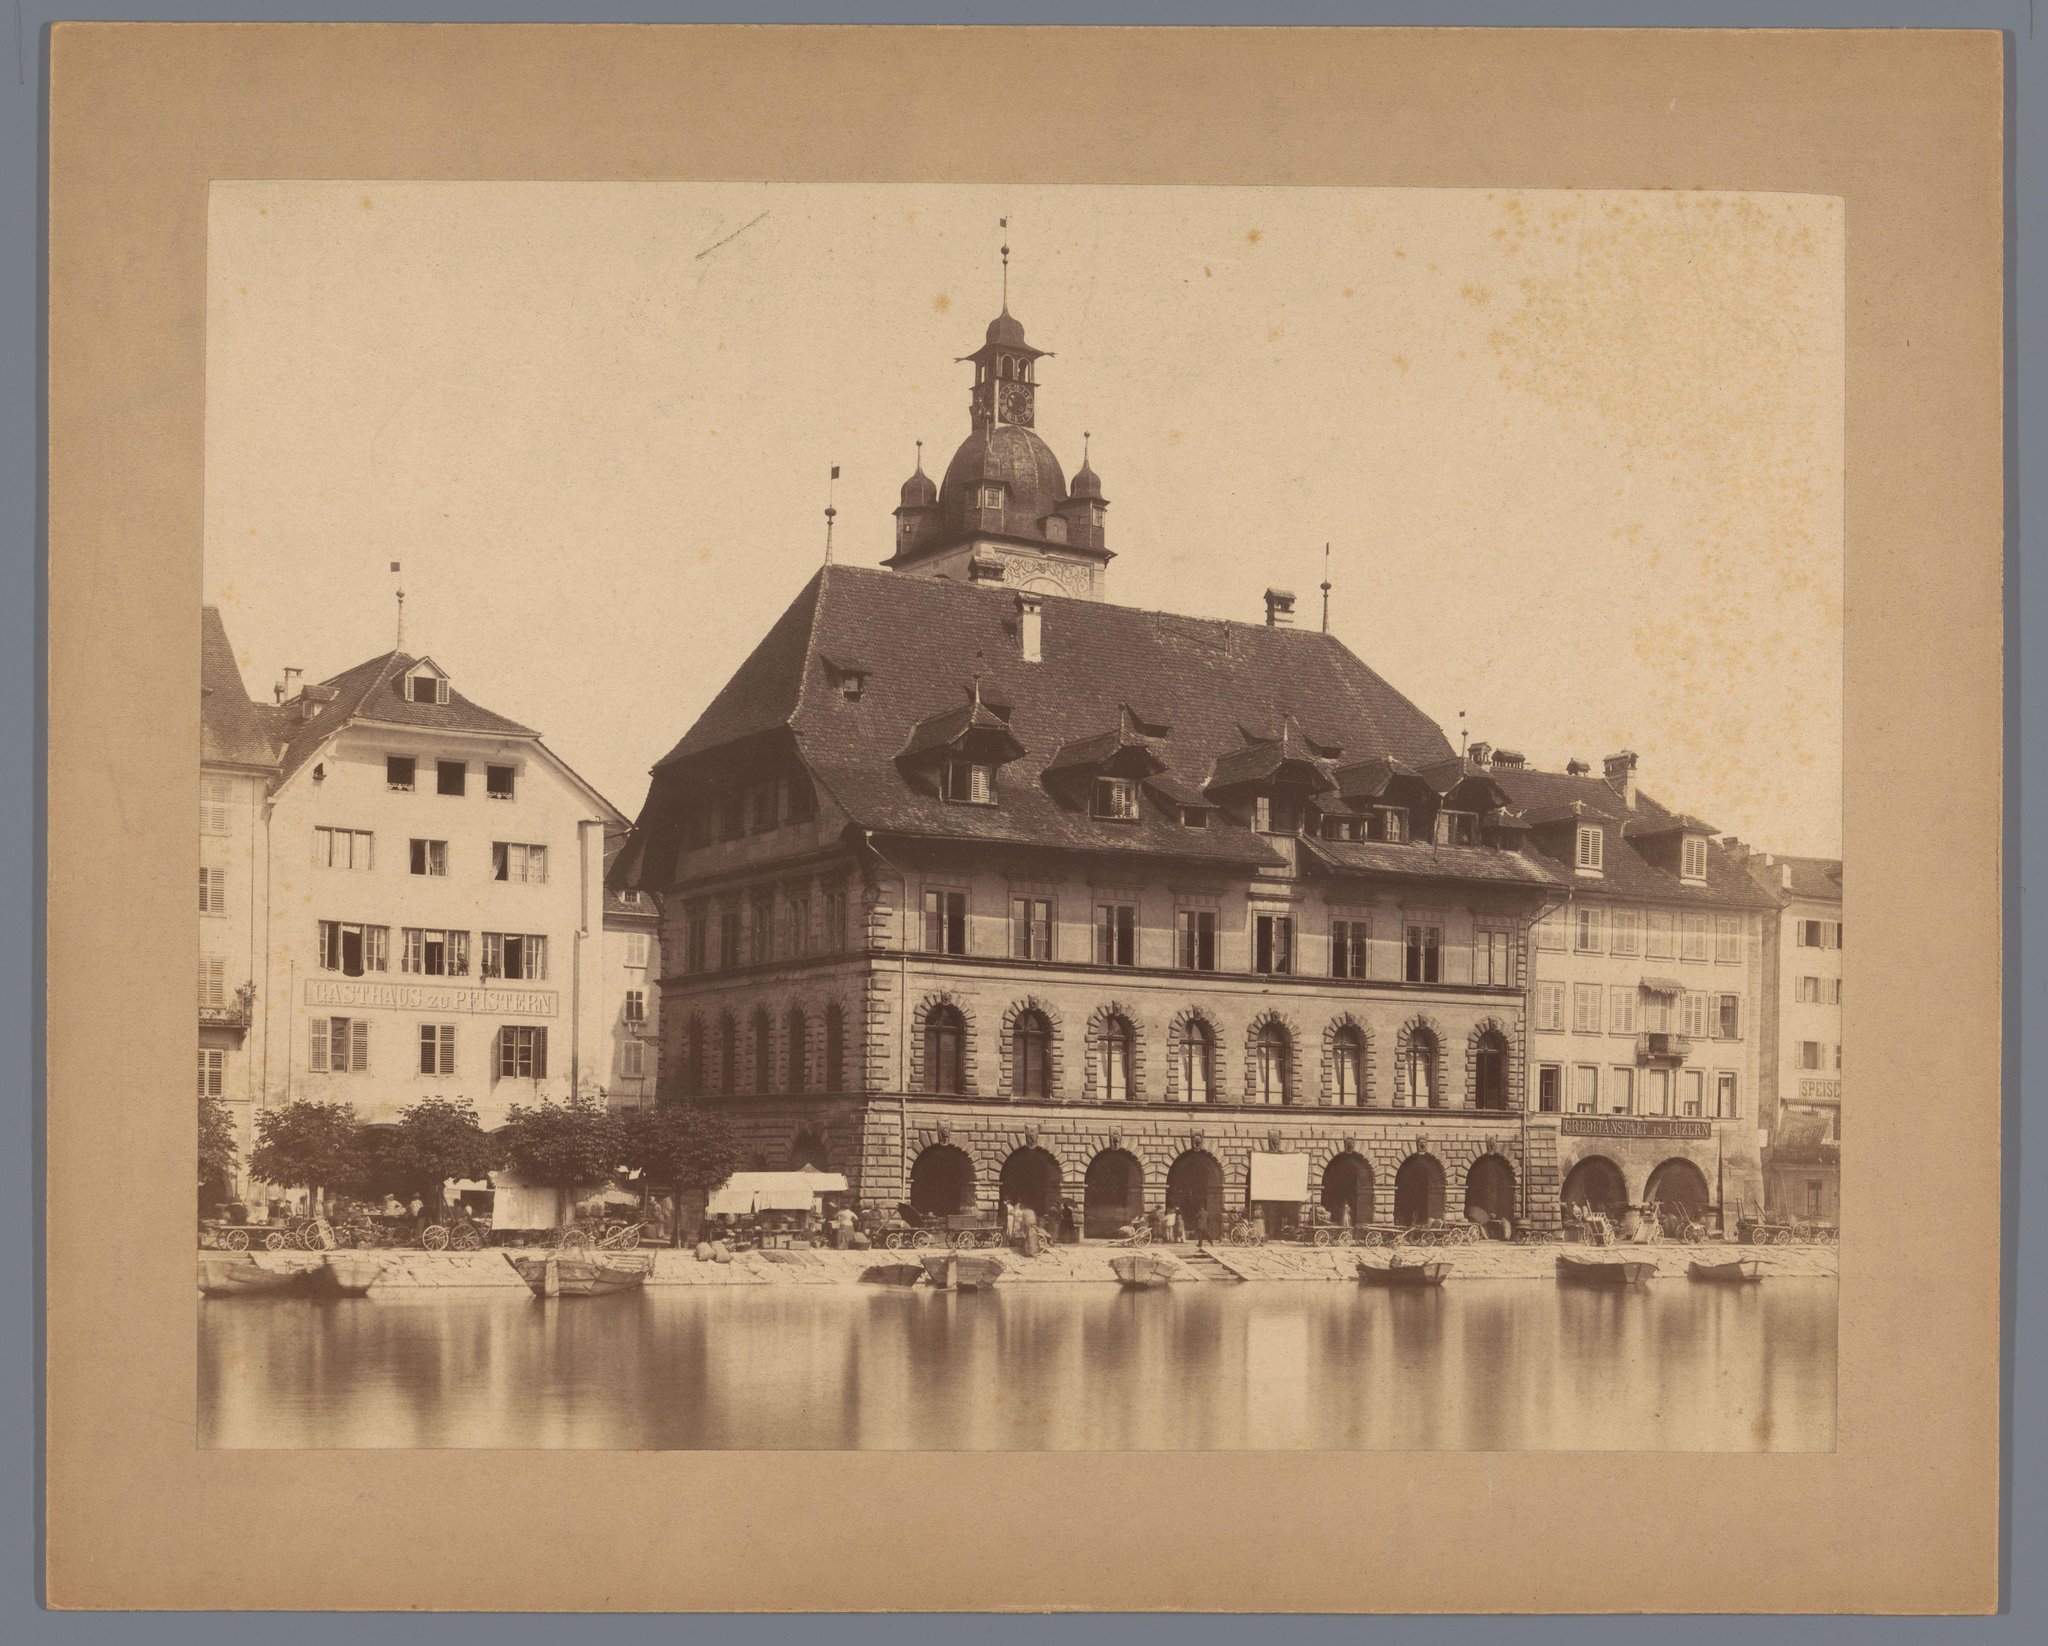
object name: photograph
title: Gezicht op het stadhuis van Luzern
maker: Anonymous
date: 1808-1889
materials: photographic support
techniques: albumen print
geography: lucerne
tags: townhall, façade (of house or building)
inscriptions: inscription: ‘Luzern. Aug. 1889. Raadhuis.’, collector's mark: ‘Kunstnijverheidschool Quellinus Amsterdam Frans Halsstraat 14.’, collector's mark: ‘Instituut voor kunst-nijverheidsonderwijs Gabriël Metsustraat No. 16, Amsterdam’